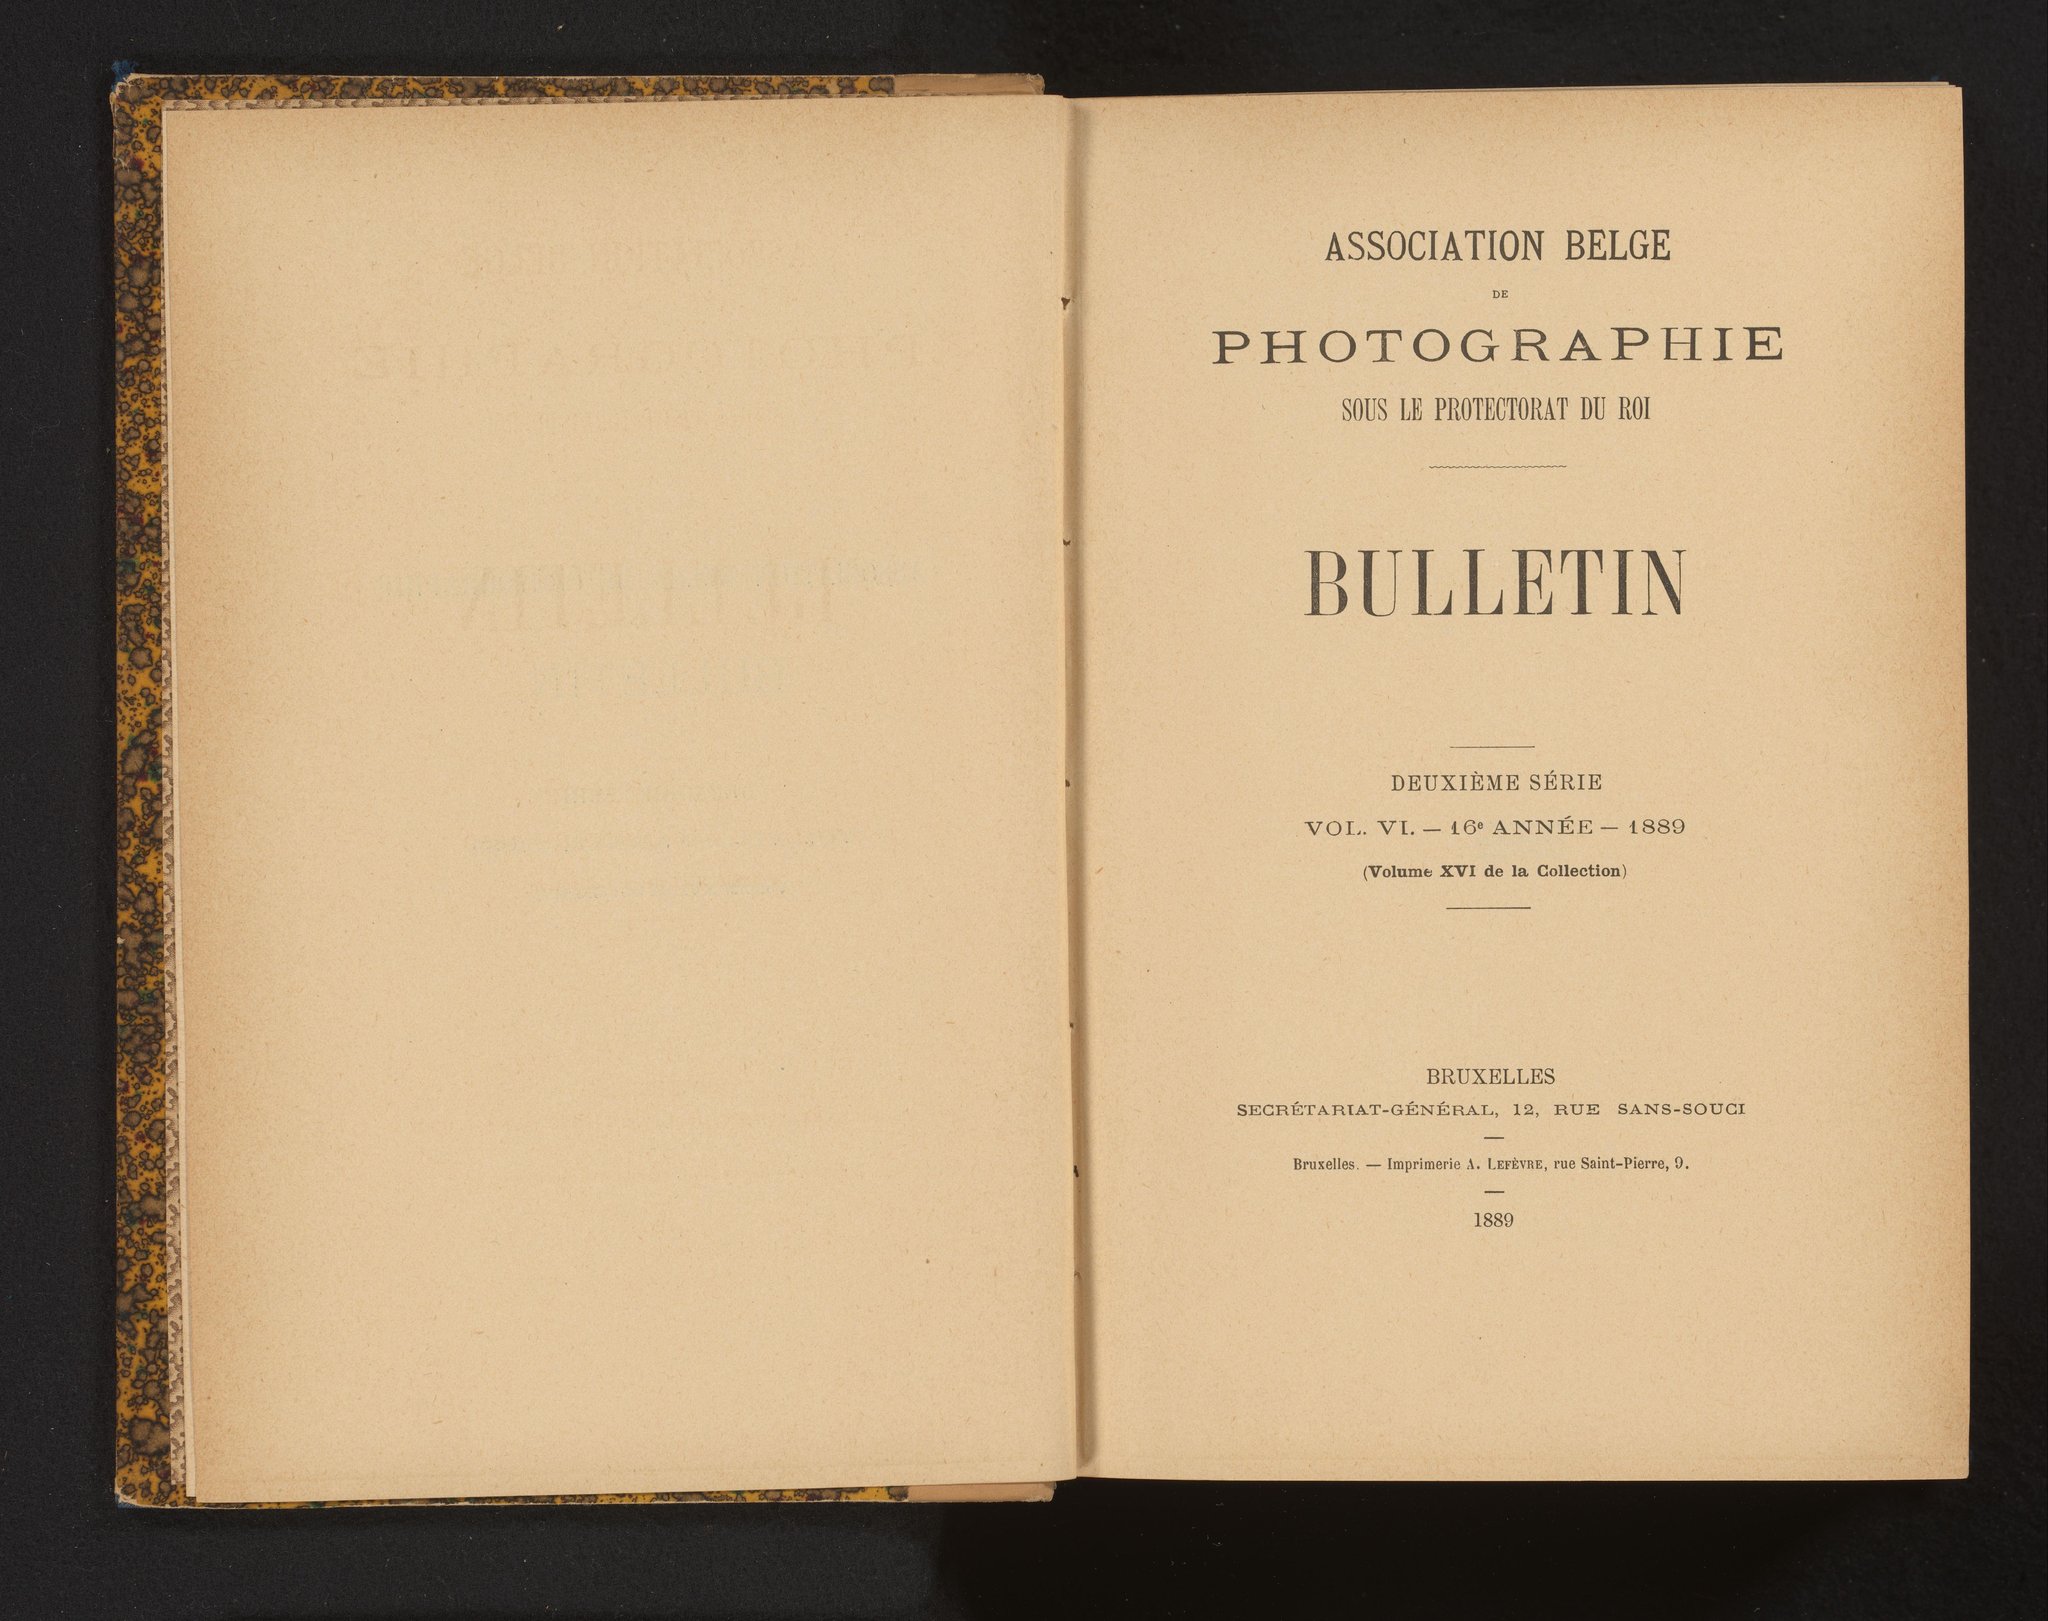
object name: book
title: Association belge de photographie bulletin 16e année: 1889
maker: a. lefèvre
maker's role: printer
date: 1889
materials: paper, cardboard, leather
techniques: marbled paper, photograph, heliotype, letterpress printing, marbling, photoaquatint, woodburytype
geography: brussels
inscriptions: inscription: ‘C’